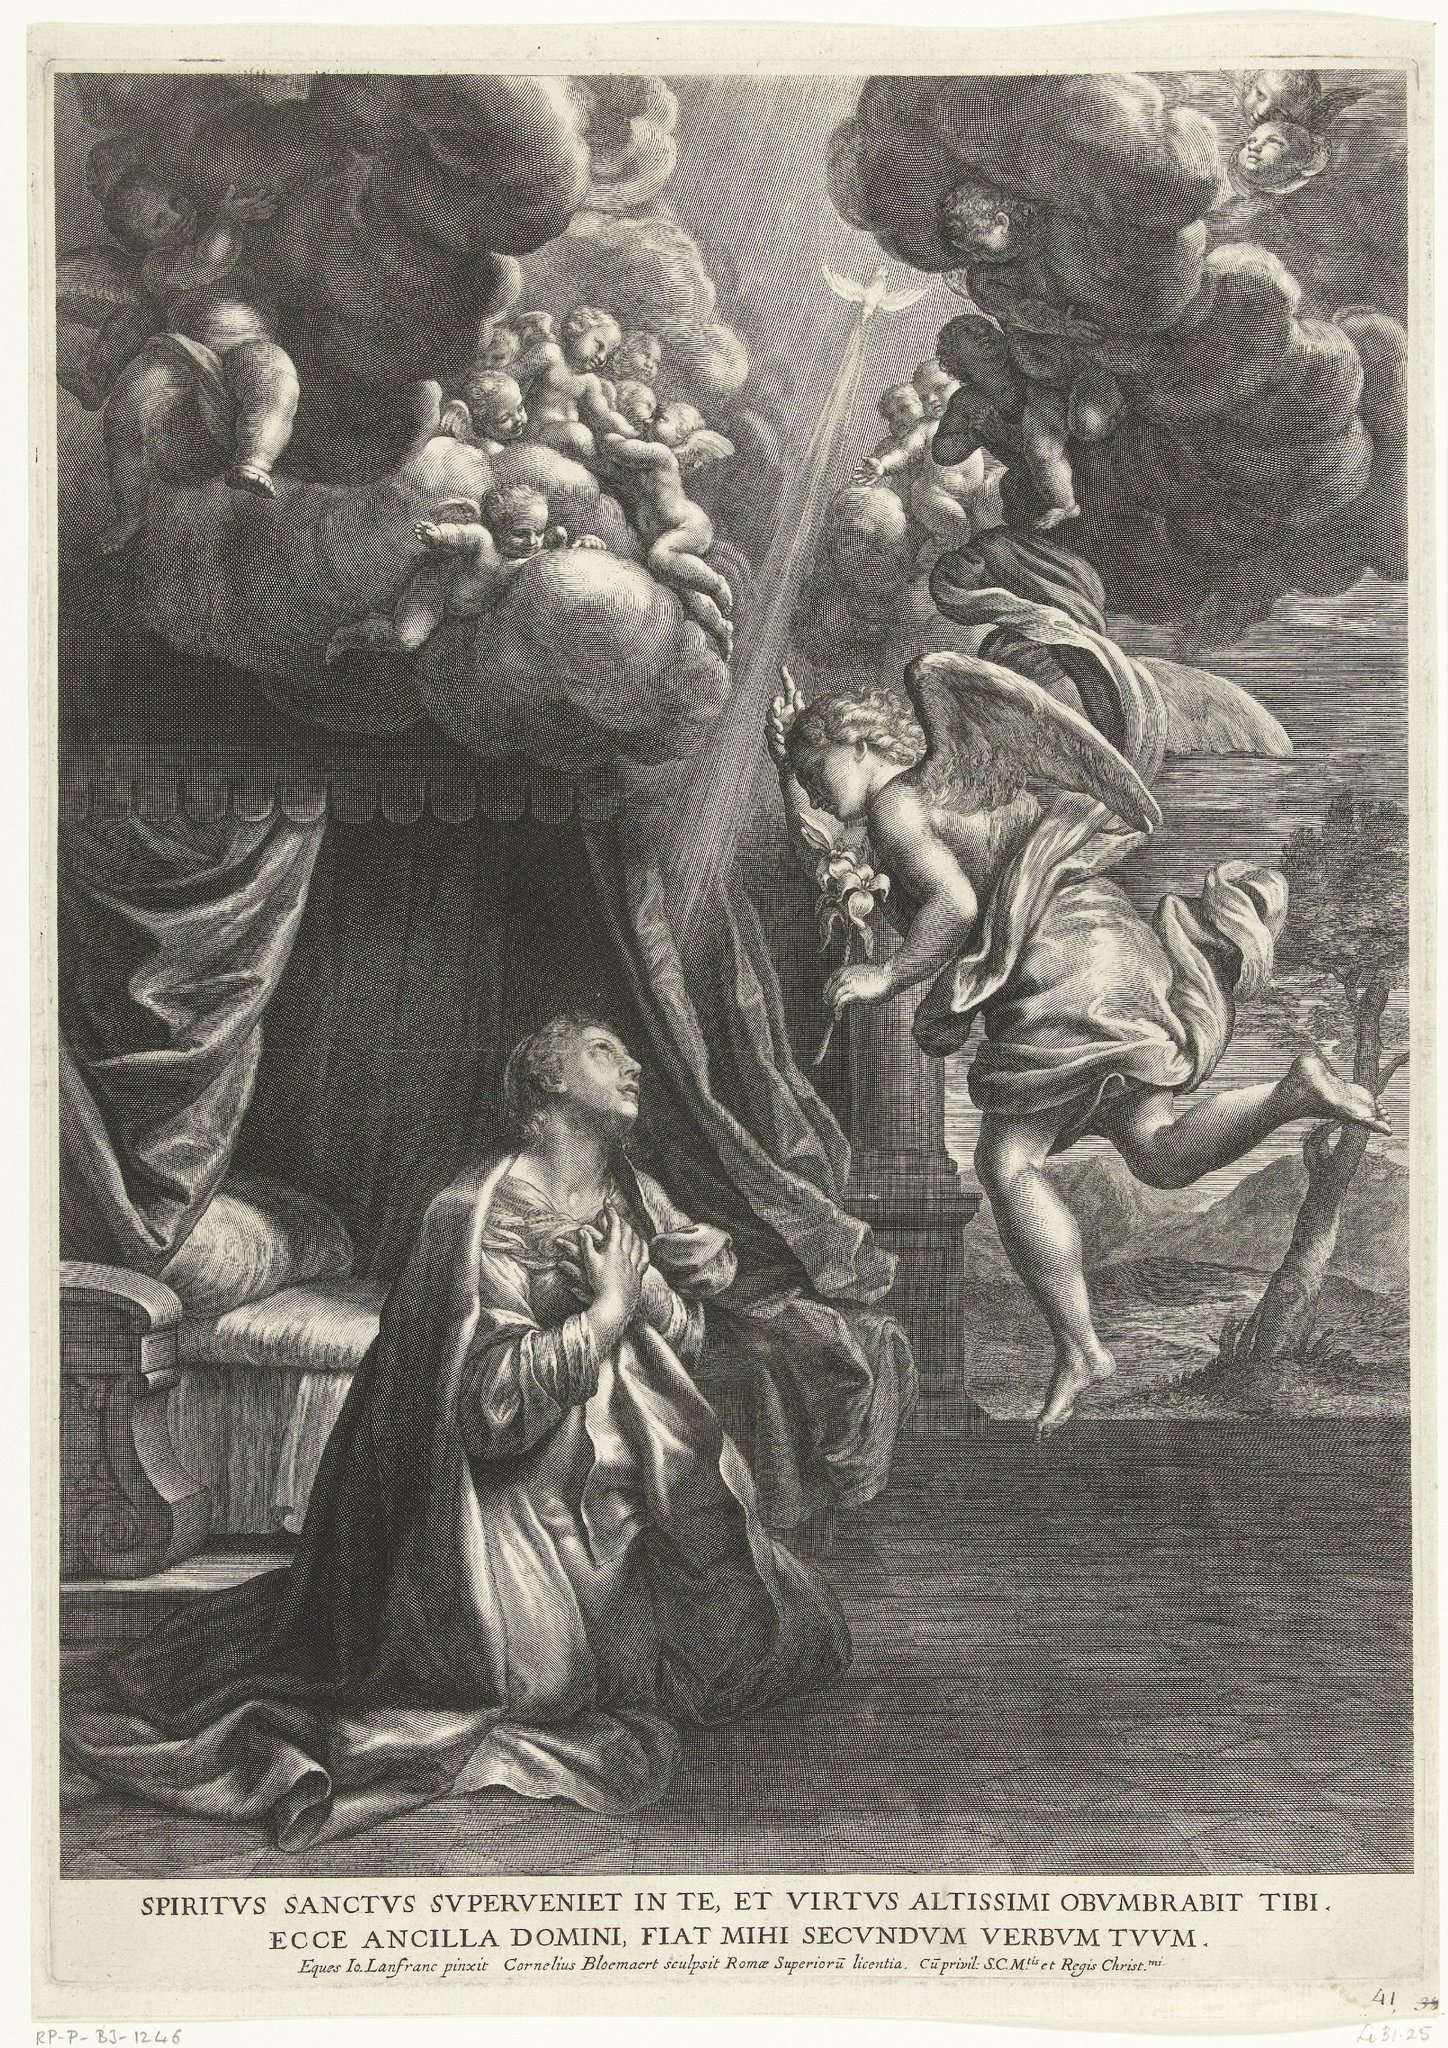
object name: print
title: Annunciatie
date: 1633-1692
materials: paper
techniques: engraving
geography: rome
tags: the annunciation: mary, usually reading, is visited by the angel (sometimes a woman overhears the conversation)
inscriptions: collector's mark: Lugt 2228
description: Een engel die met de rechterhand naar de hemel wijst, verkondigt aan de knielende Maria de geboorte van Christus. De engel wordt vergezeld door een aantal kleine engeltjes.